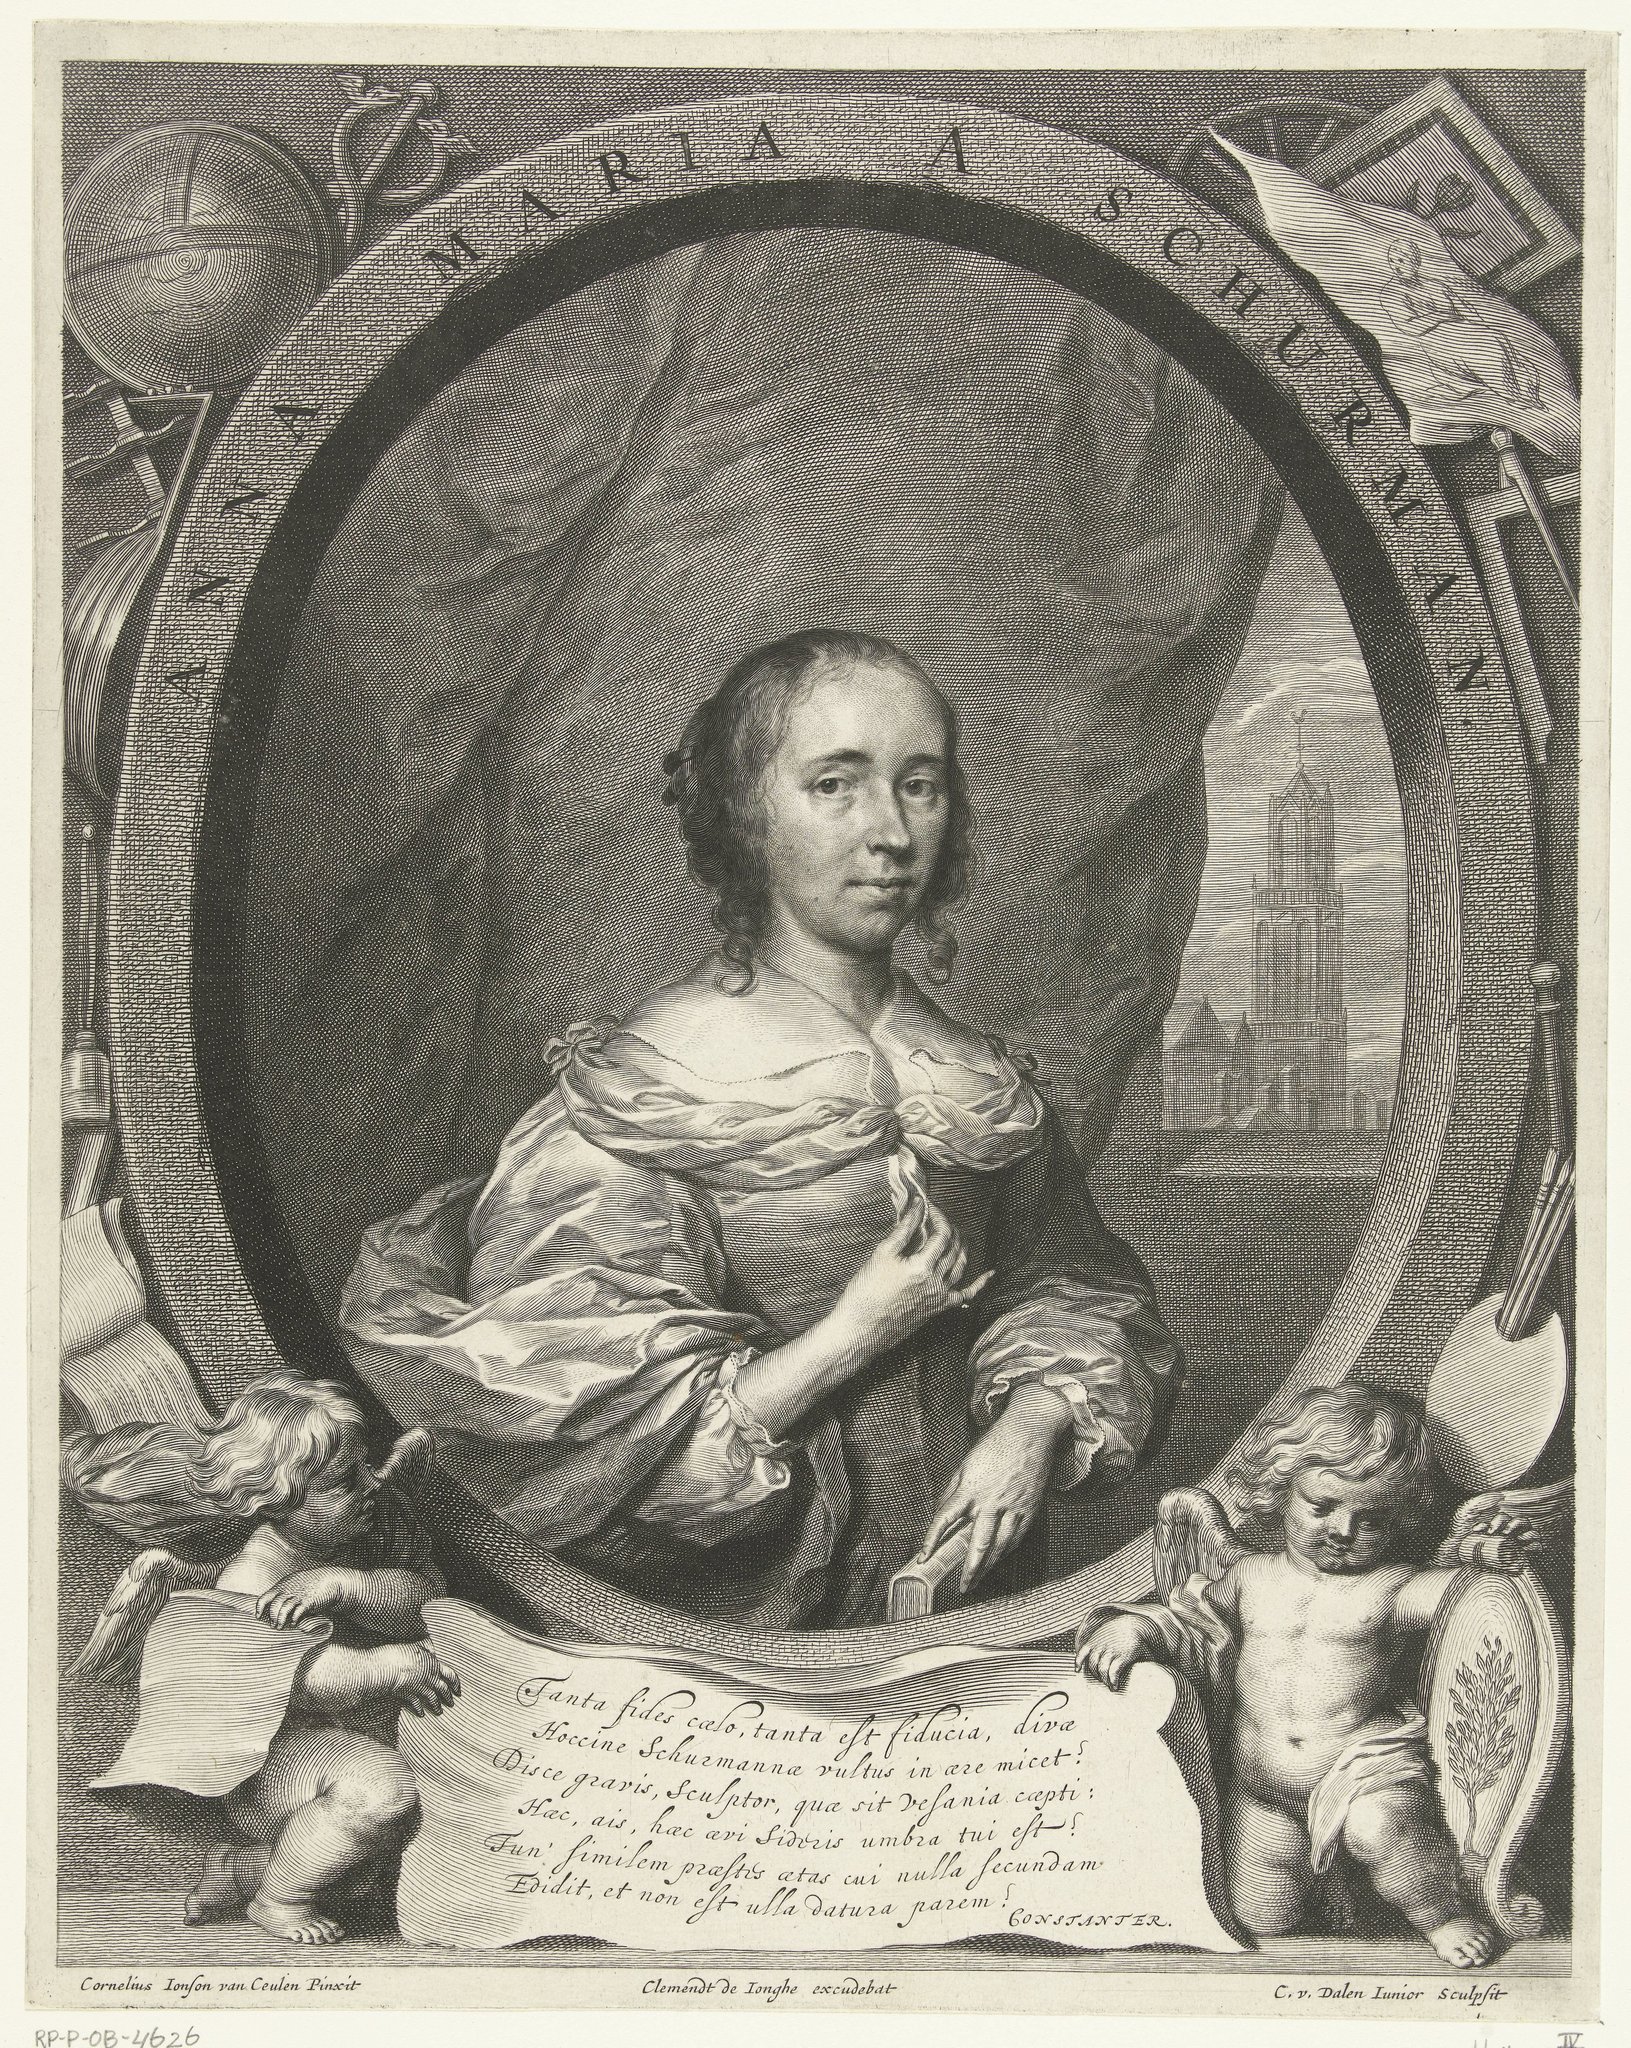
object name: print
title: Portret van Anna Maria van Schurman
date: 1648-1664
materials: paper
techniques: engraving, etching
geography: amsterdam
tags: print maker, anna maria van schurman, portrait, self-portrait of painter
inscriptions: collector's mark: Lugt 240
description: Portret van Anna Maria van Schurman, staand ten halven lijve voor draperie naast uitzicht op Domtoren te Utrecht in ovale omlijsting. Rond het ovaal attributen als een globe, luit en teken- en schildersmaterialen. Onder de lijst een blad met een vers vastgehouden door twee kleine engelen.